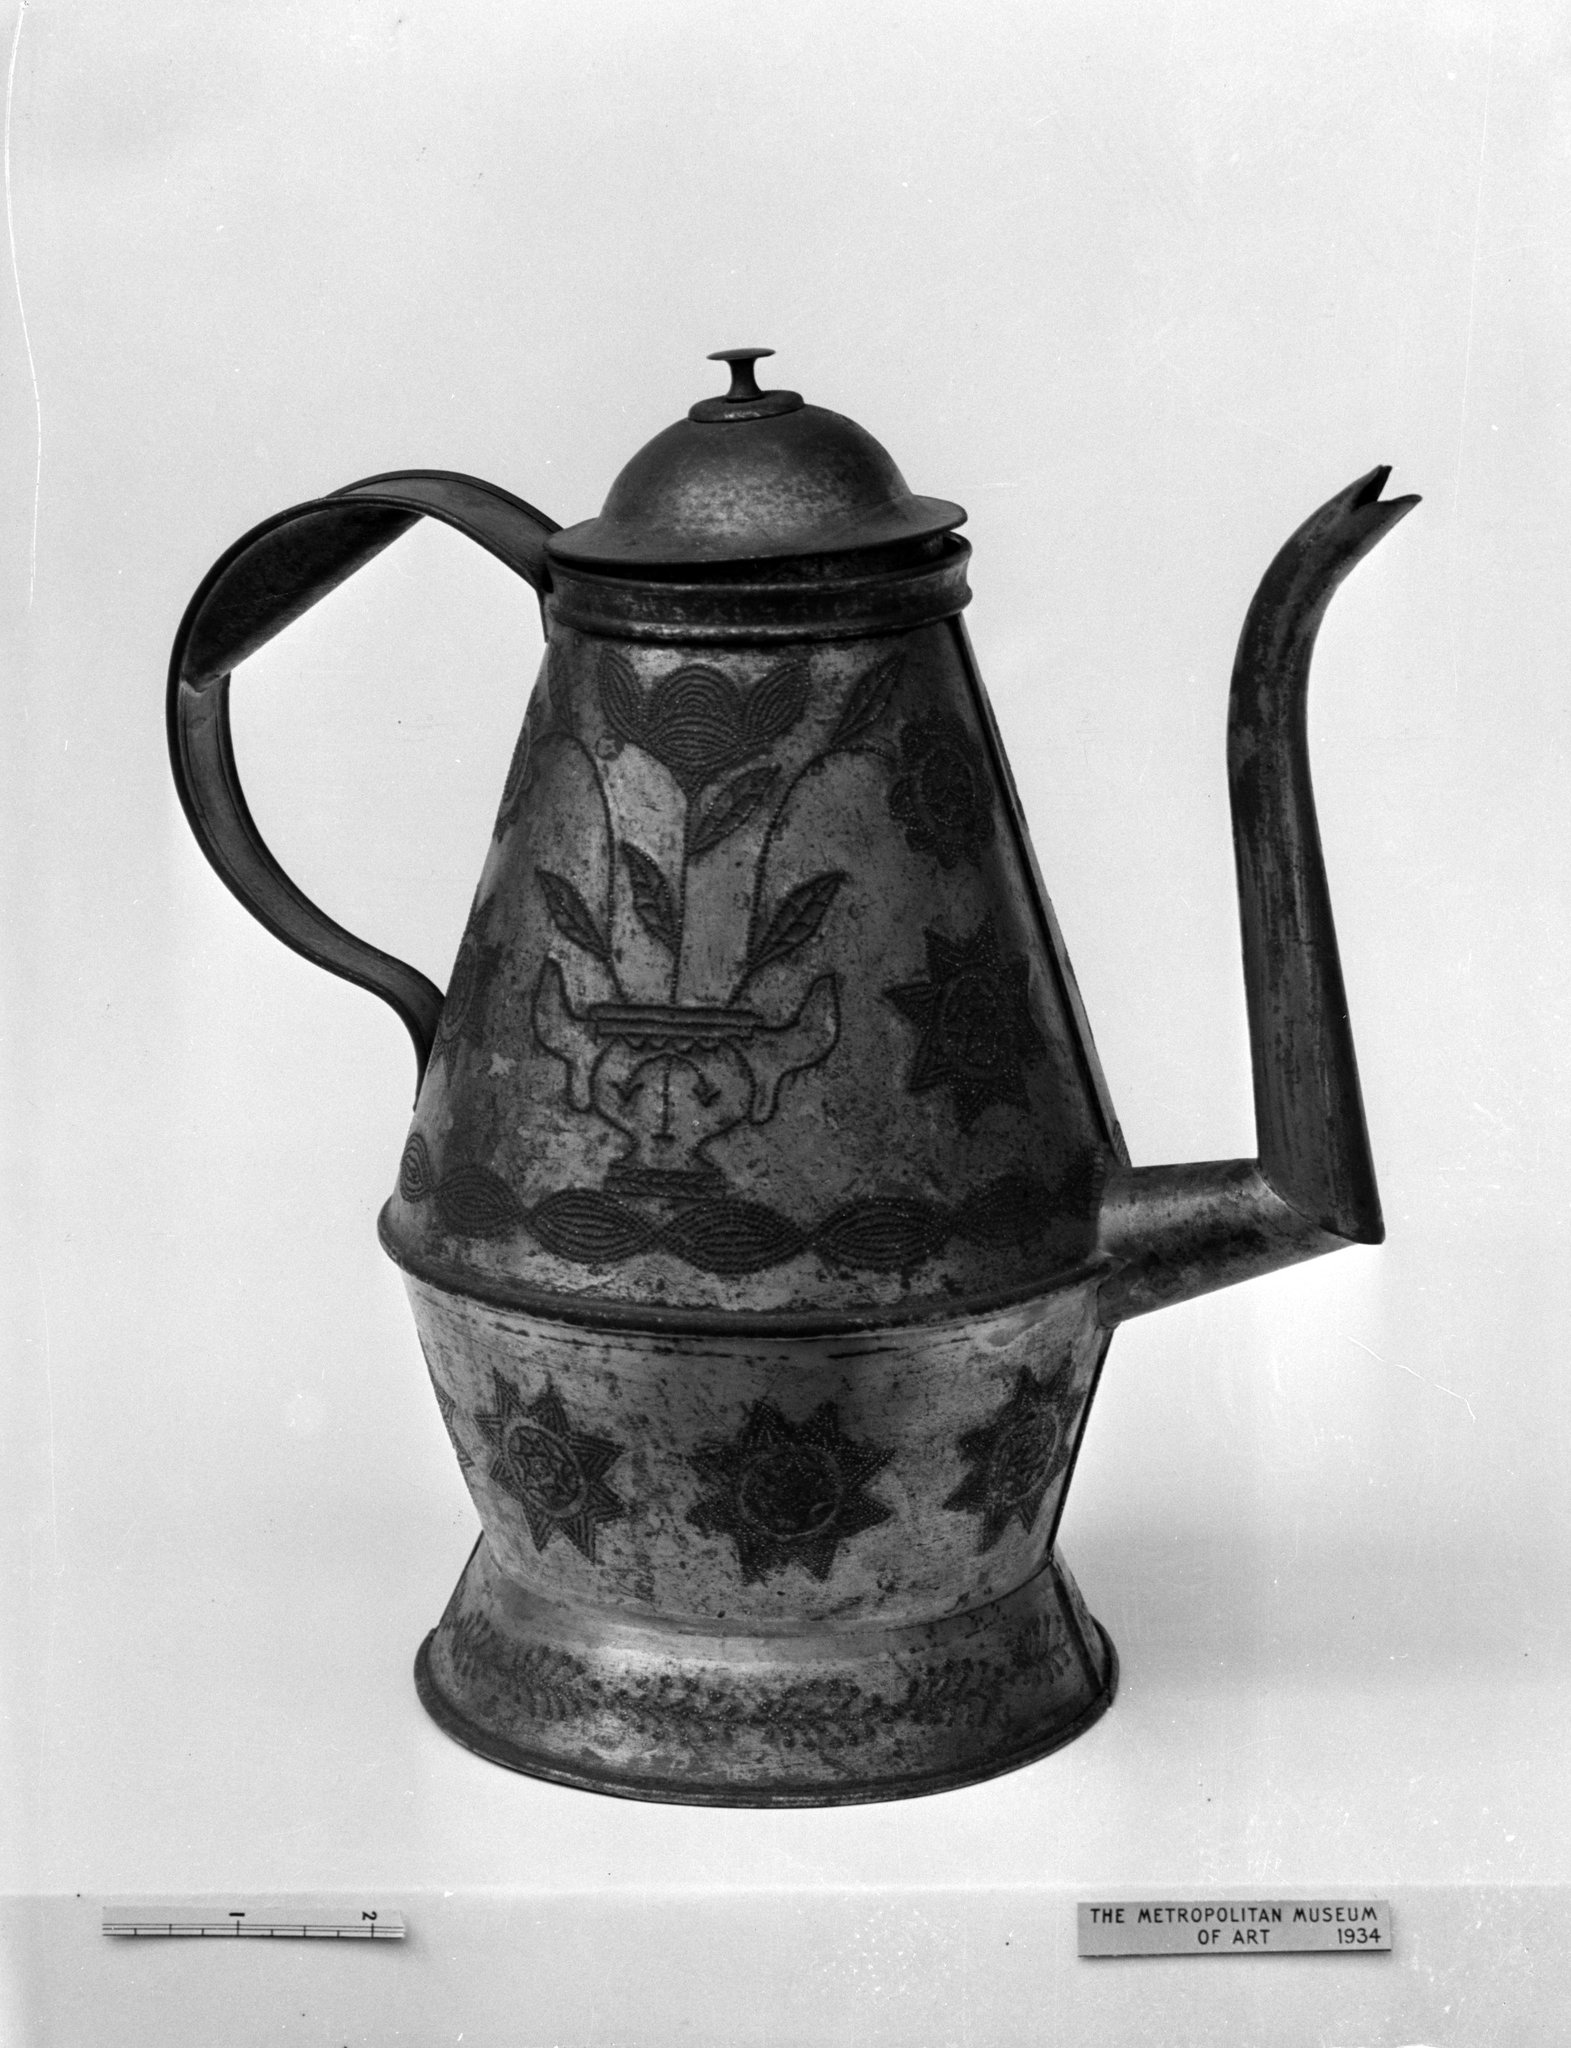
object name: coffeepot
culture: american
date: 1840-1870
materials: iron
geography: united states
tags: flowers